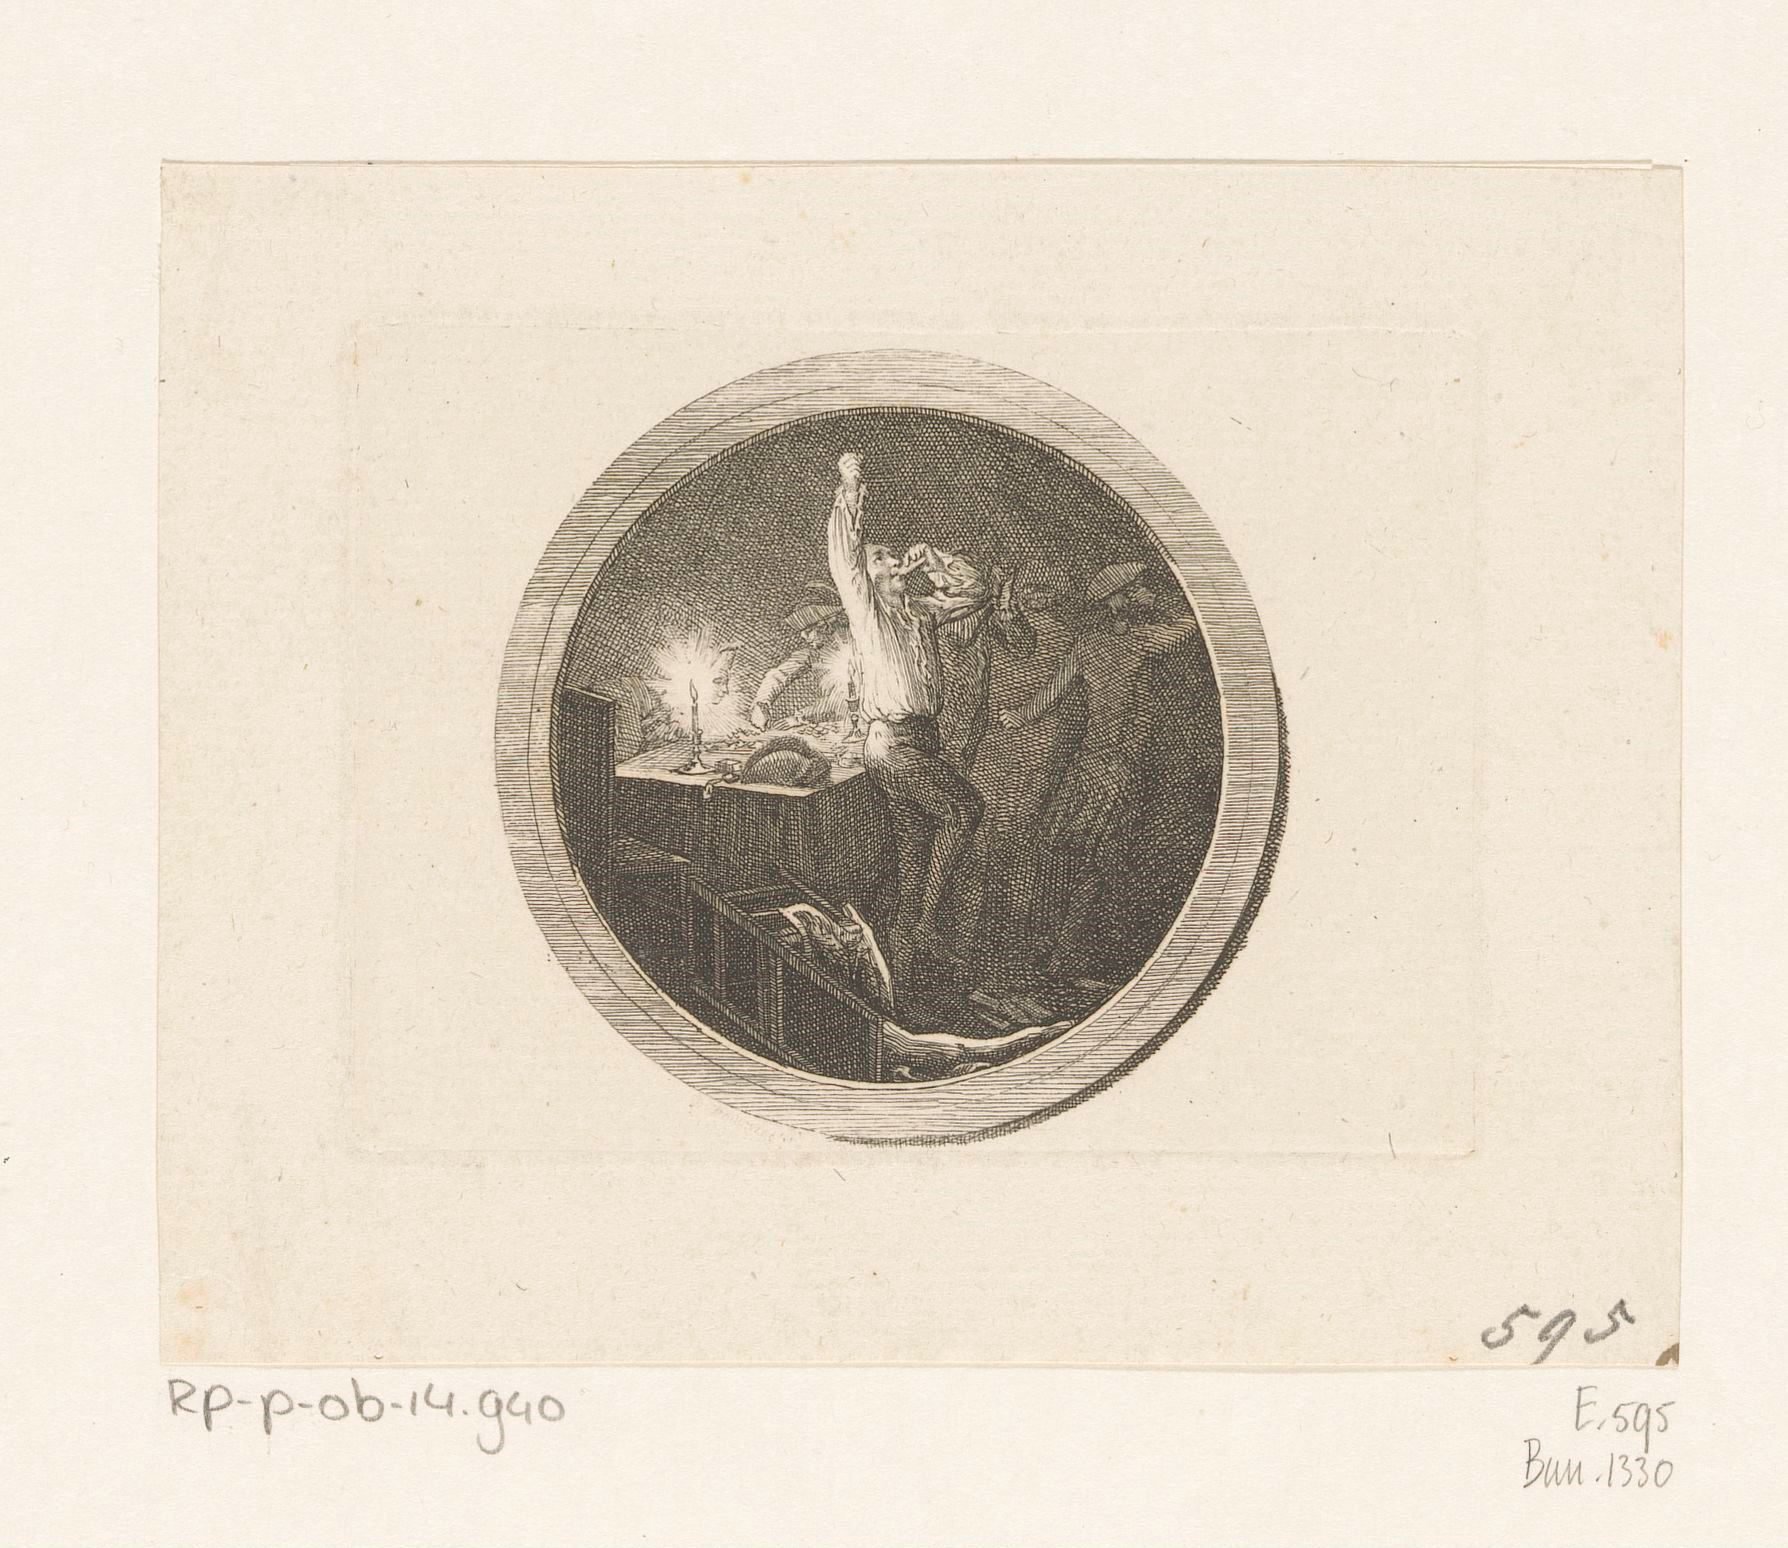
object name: print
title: Man naast goktafel, met gebalde vuist in de lucht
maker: daniel nikolaus chodowiecki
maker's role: draughtsman, print maker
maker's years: 1726-1801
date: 1787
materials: paper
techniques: etching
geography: berlin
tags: arm raised, with fist, drunkard, candle, gaming den, gambling den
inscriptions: collector's mark: Lugt 2228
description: Prent uit: Bretzner, Christian Friedrich. Das Leben eines Lüderlichen: Ein moralisch-satyrisches Gemälde (...). 3 dln. Leipzig: Friedrich Gotthold Jacobäer, 1787, dl. 3.